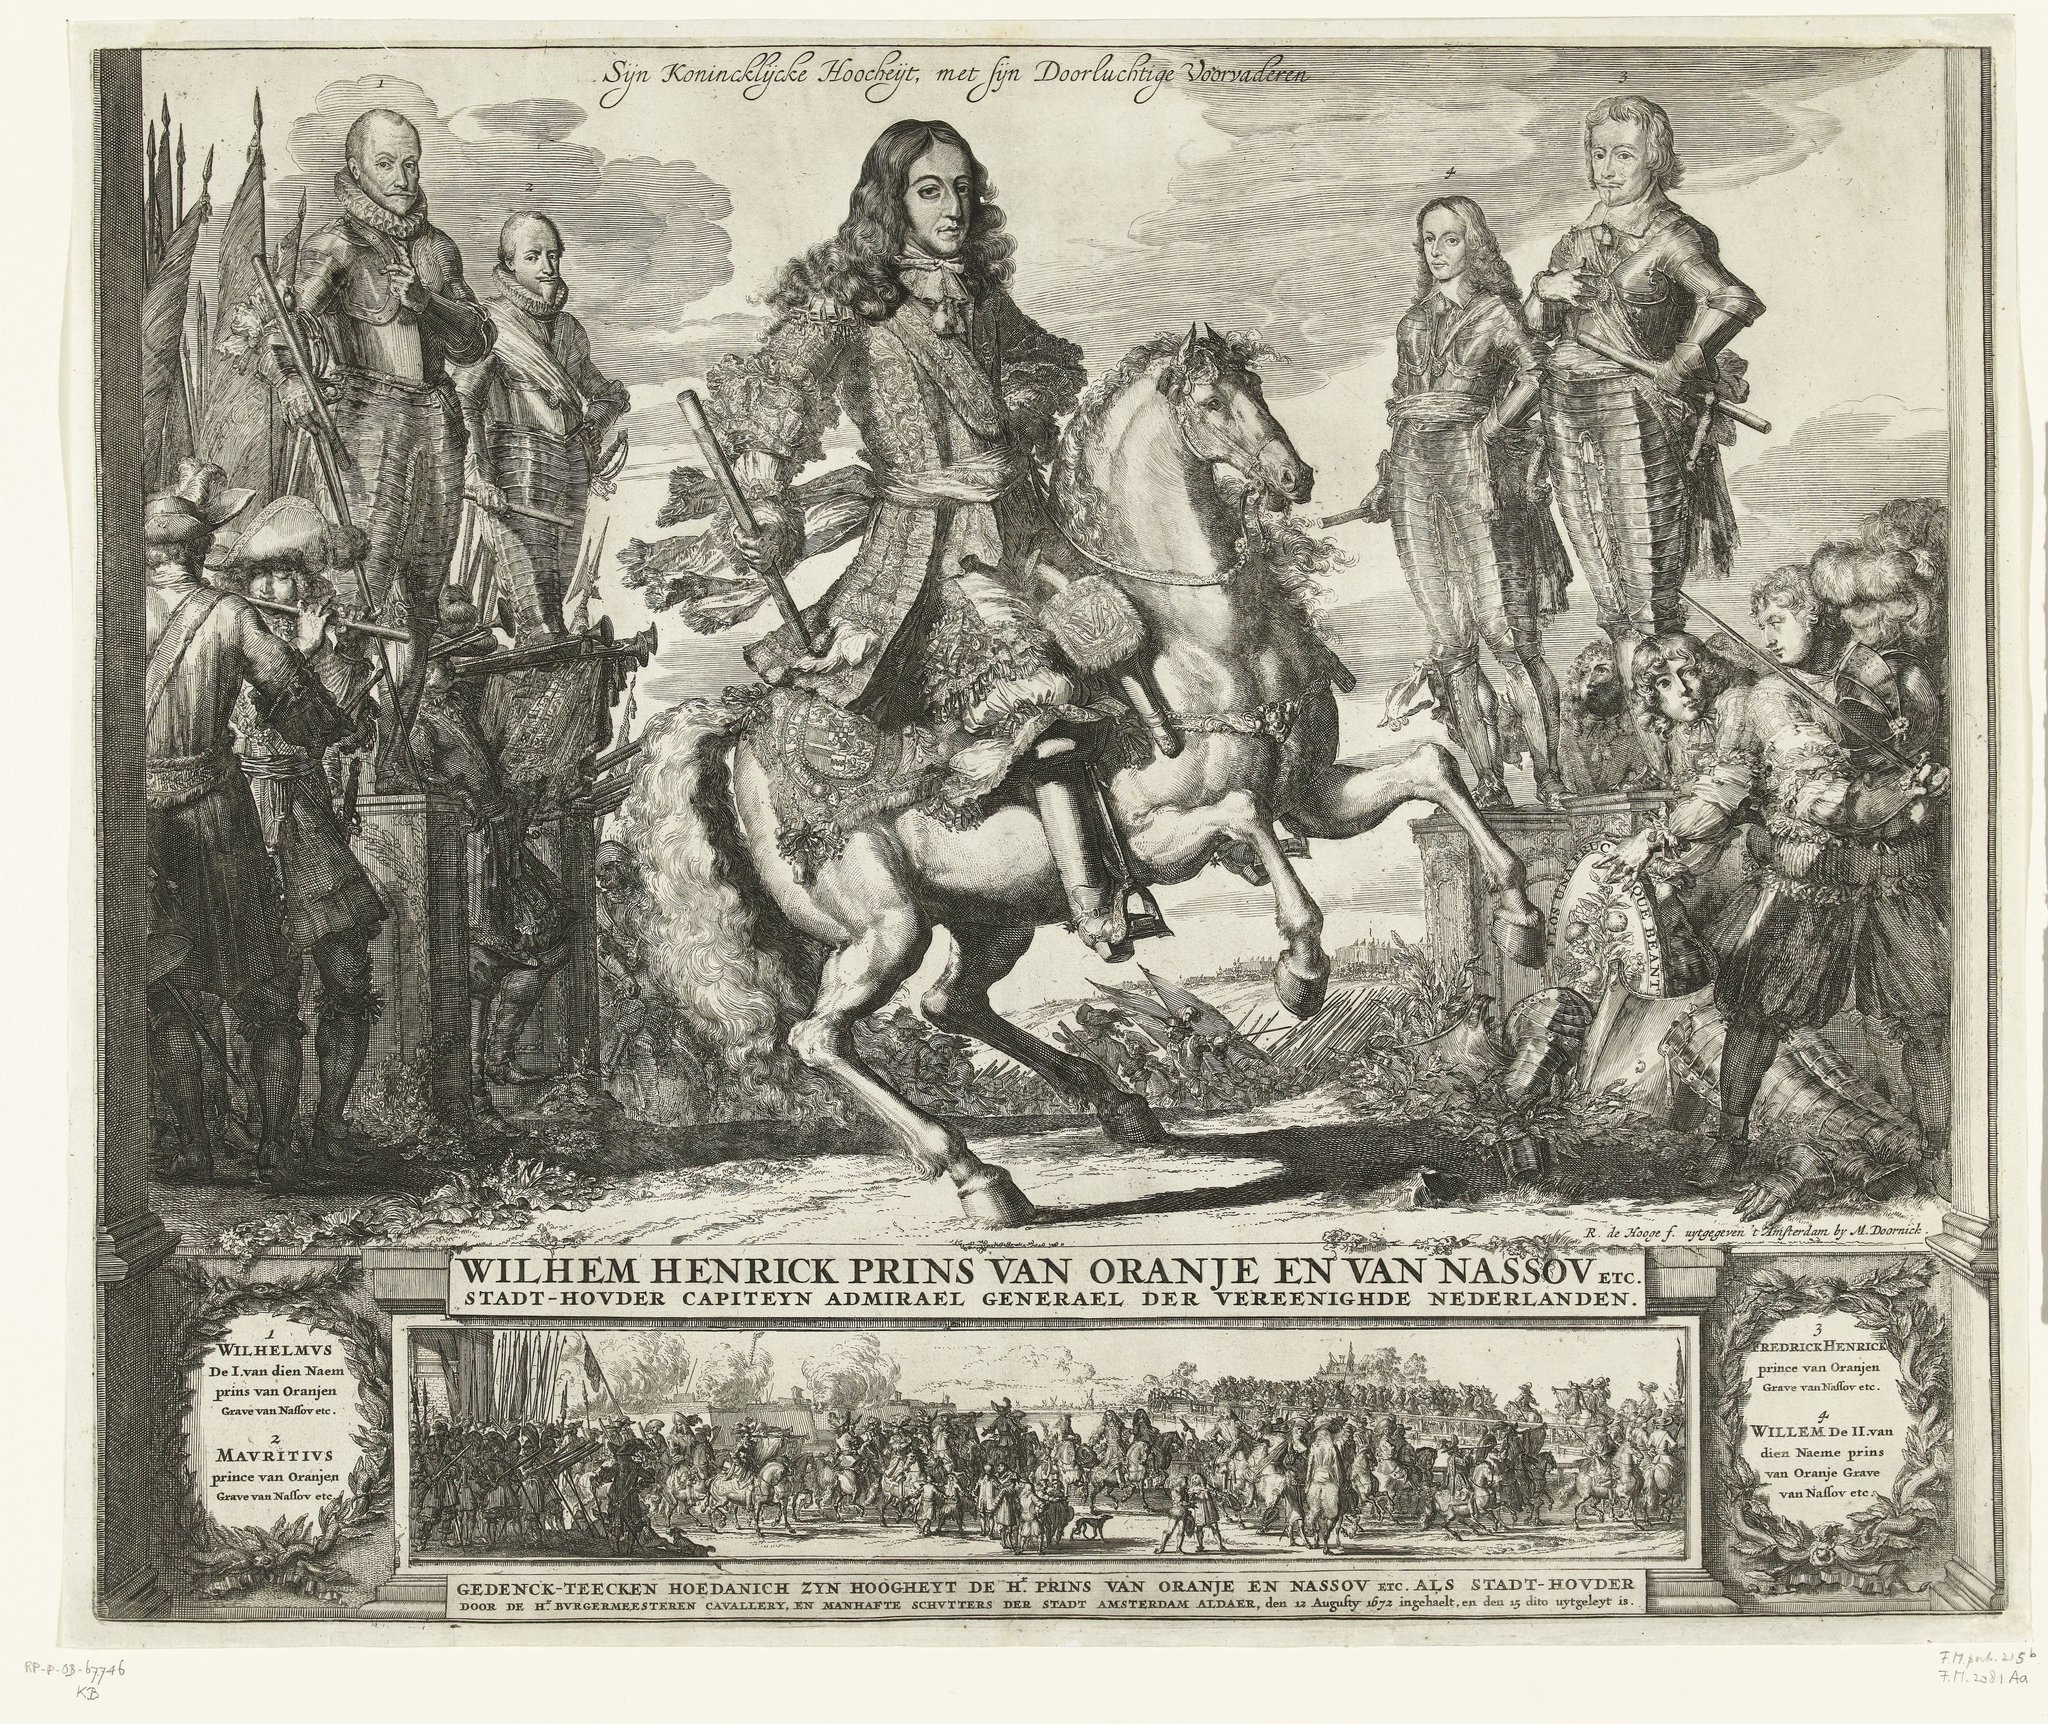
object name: print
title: Ruiterportret van Willem III als stadhouder en kapitein-generaal van de verenigde Nederlanden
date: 1672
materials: paper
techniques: engraving, etching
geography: amsterdam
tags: william iii (prince of orange and king of england, scotland, and ireland), frederick henry (prince of orange), william ii (prince of orange), william i (prince of orange), the hague, maurice (prince of orange), knighthood order (garter) - insignia of a knighthood order, e.g.: badge, chain, amsterdam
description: Ruiterportret van Willem III als stadhouder en kapitein-generaal van de verenigde Nederlanden. De prins is afgebeeld tussen standbeelden van zijn voorgangers genummerd 1-4. Links: Willem van Oranje en prins Maurits. Rechts: Frederik Hendrik en Willem II. Onderaan een voorstelling van de uittocht van Willem III te Amsterdam op 15 augustus 1672.